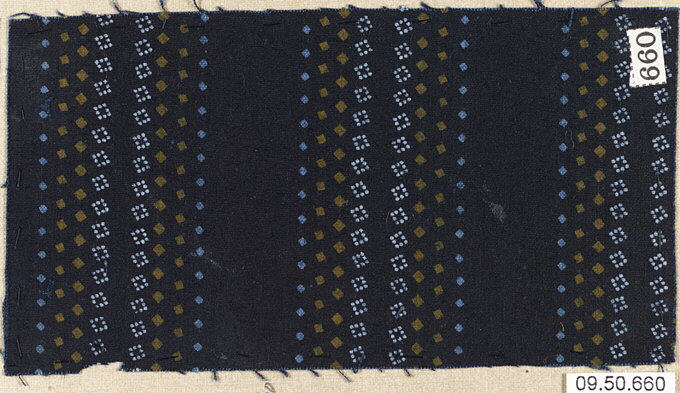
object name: piece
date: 1801-1900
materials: cotton